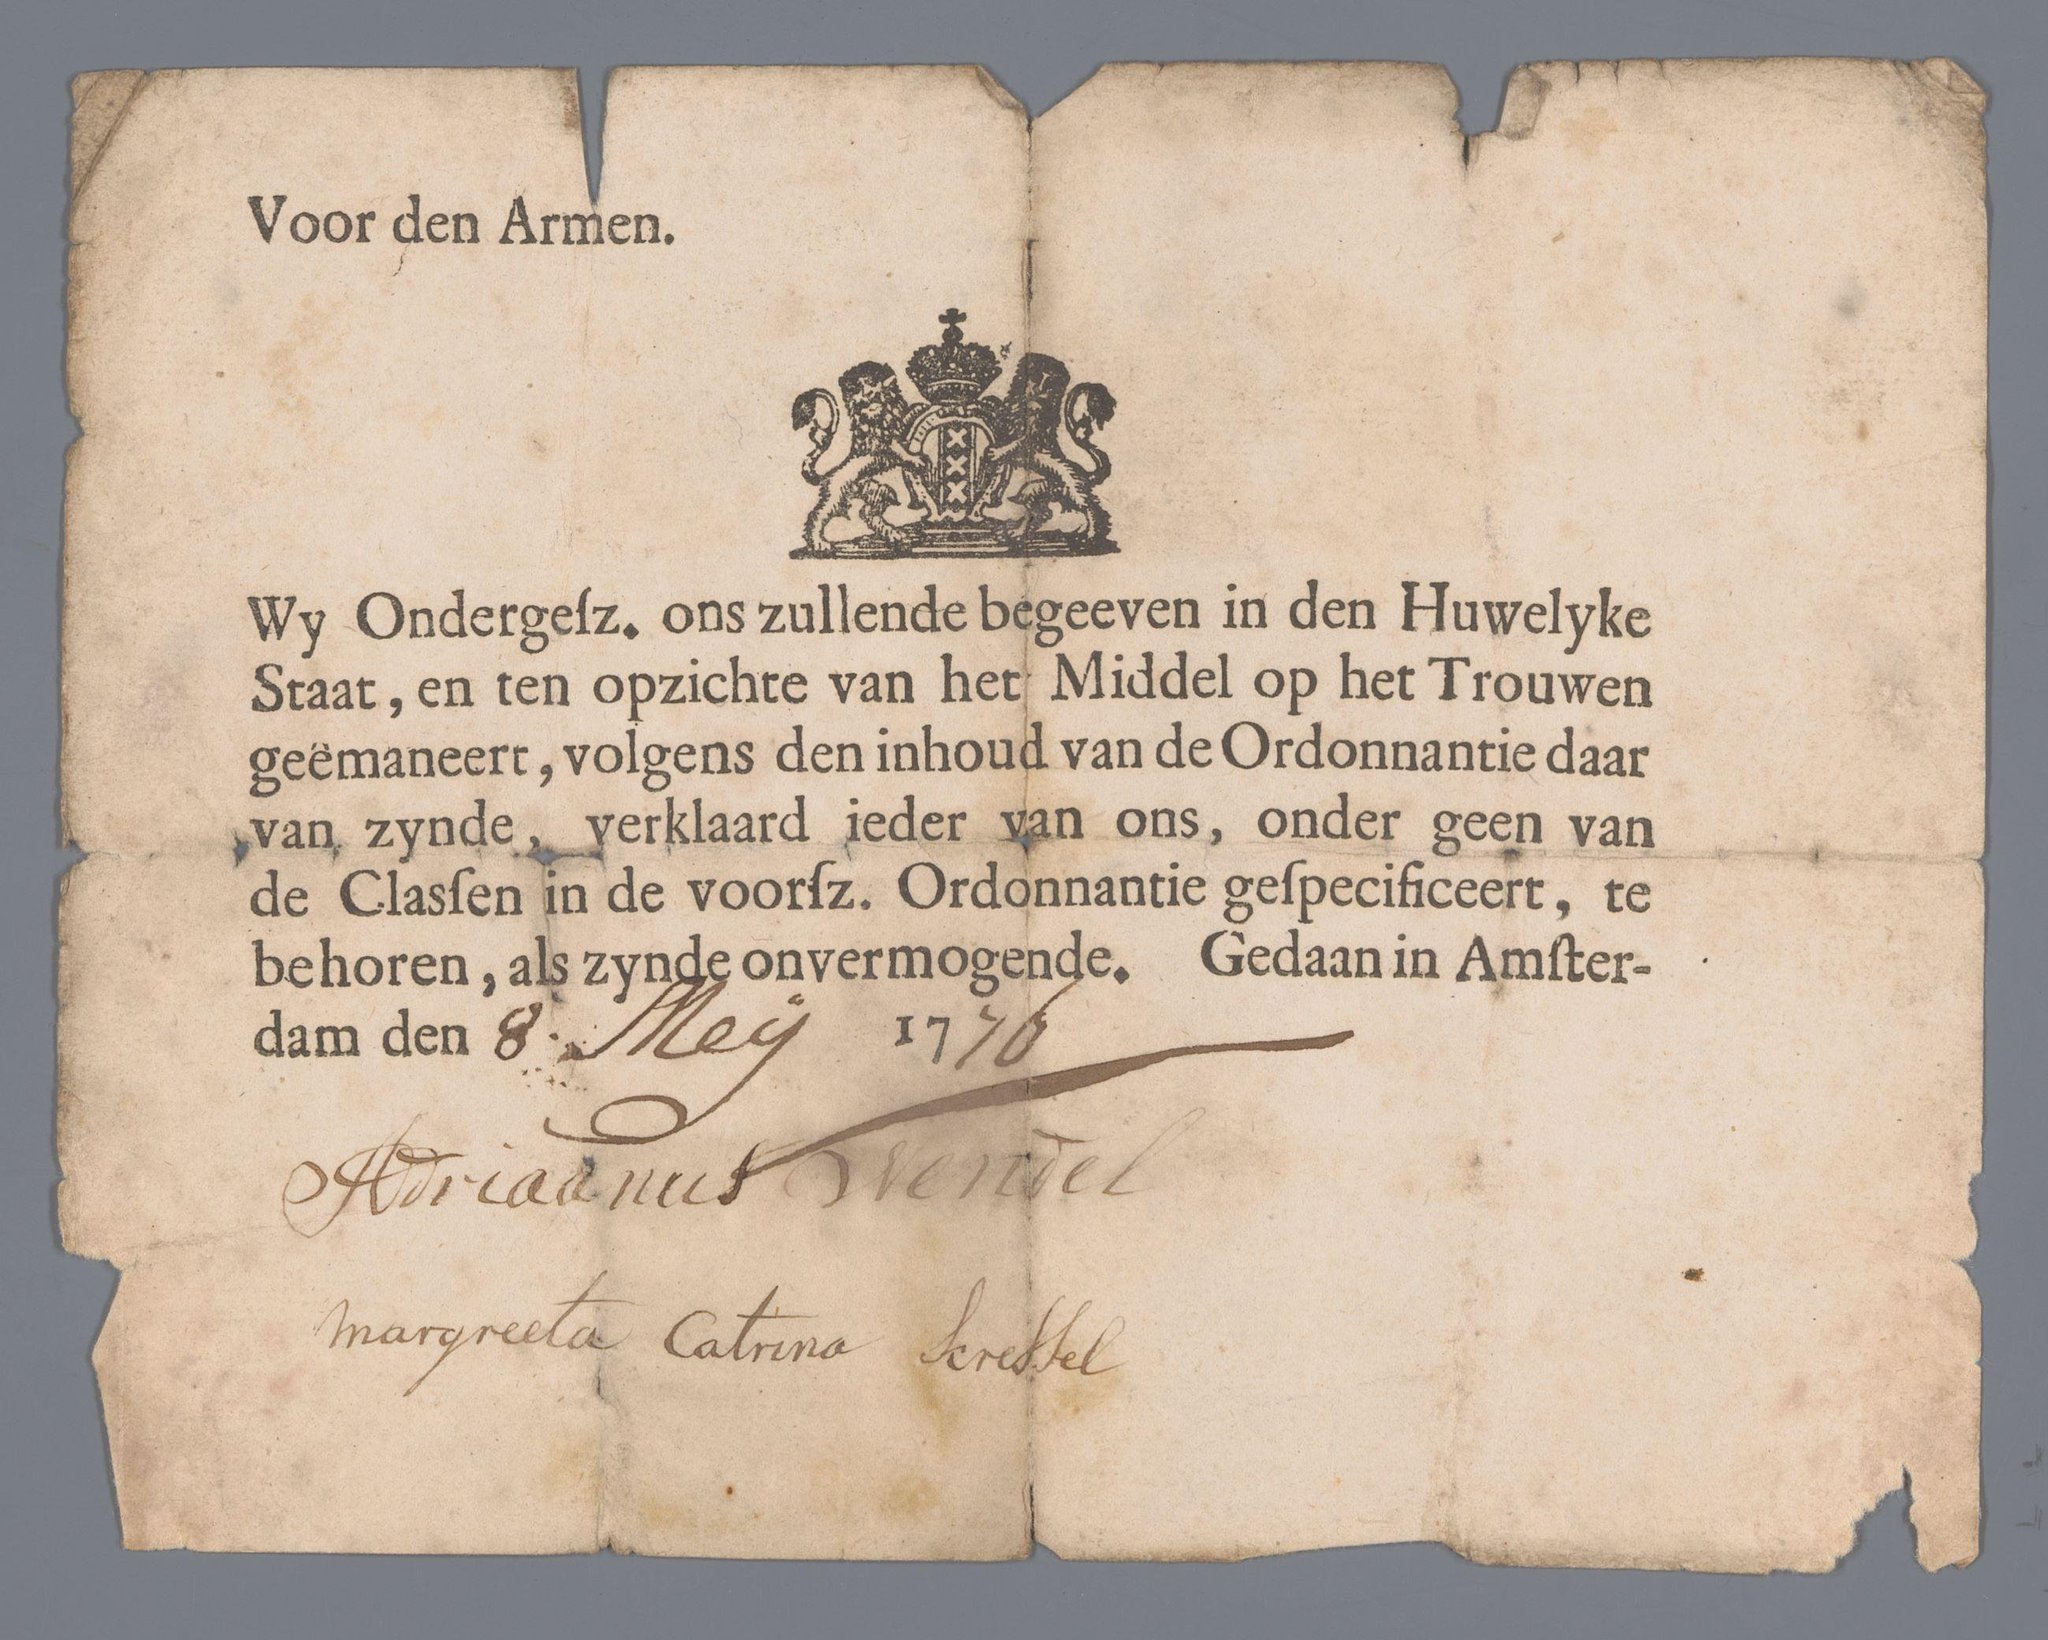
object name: document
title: Voor de Armen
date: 1776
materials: paper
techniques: printing, writing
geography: amsterdam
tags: adrianus wendel, margaretha catharina kressel, amsterdam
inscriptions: date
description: Eénzijdig bedrukt document waarin de ondergetekenden Adrianus Wendel en Margaretha Catharina Kressel in verband met hun huwelijk verklaren onvermogend te zijn. Gesigneerd en gedateerd.